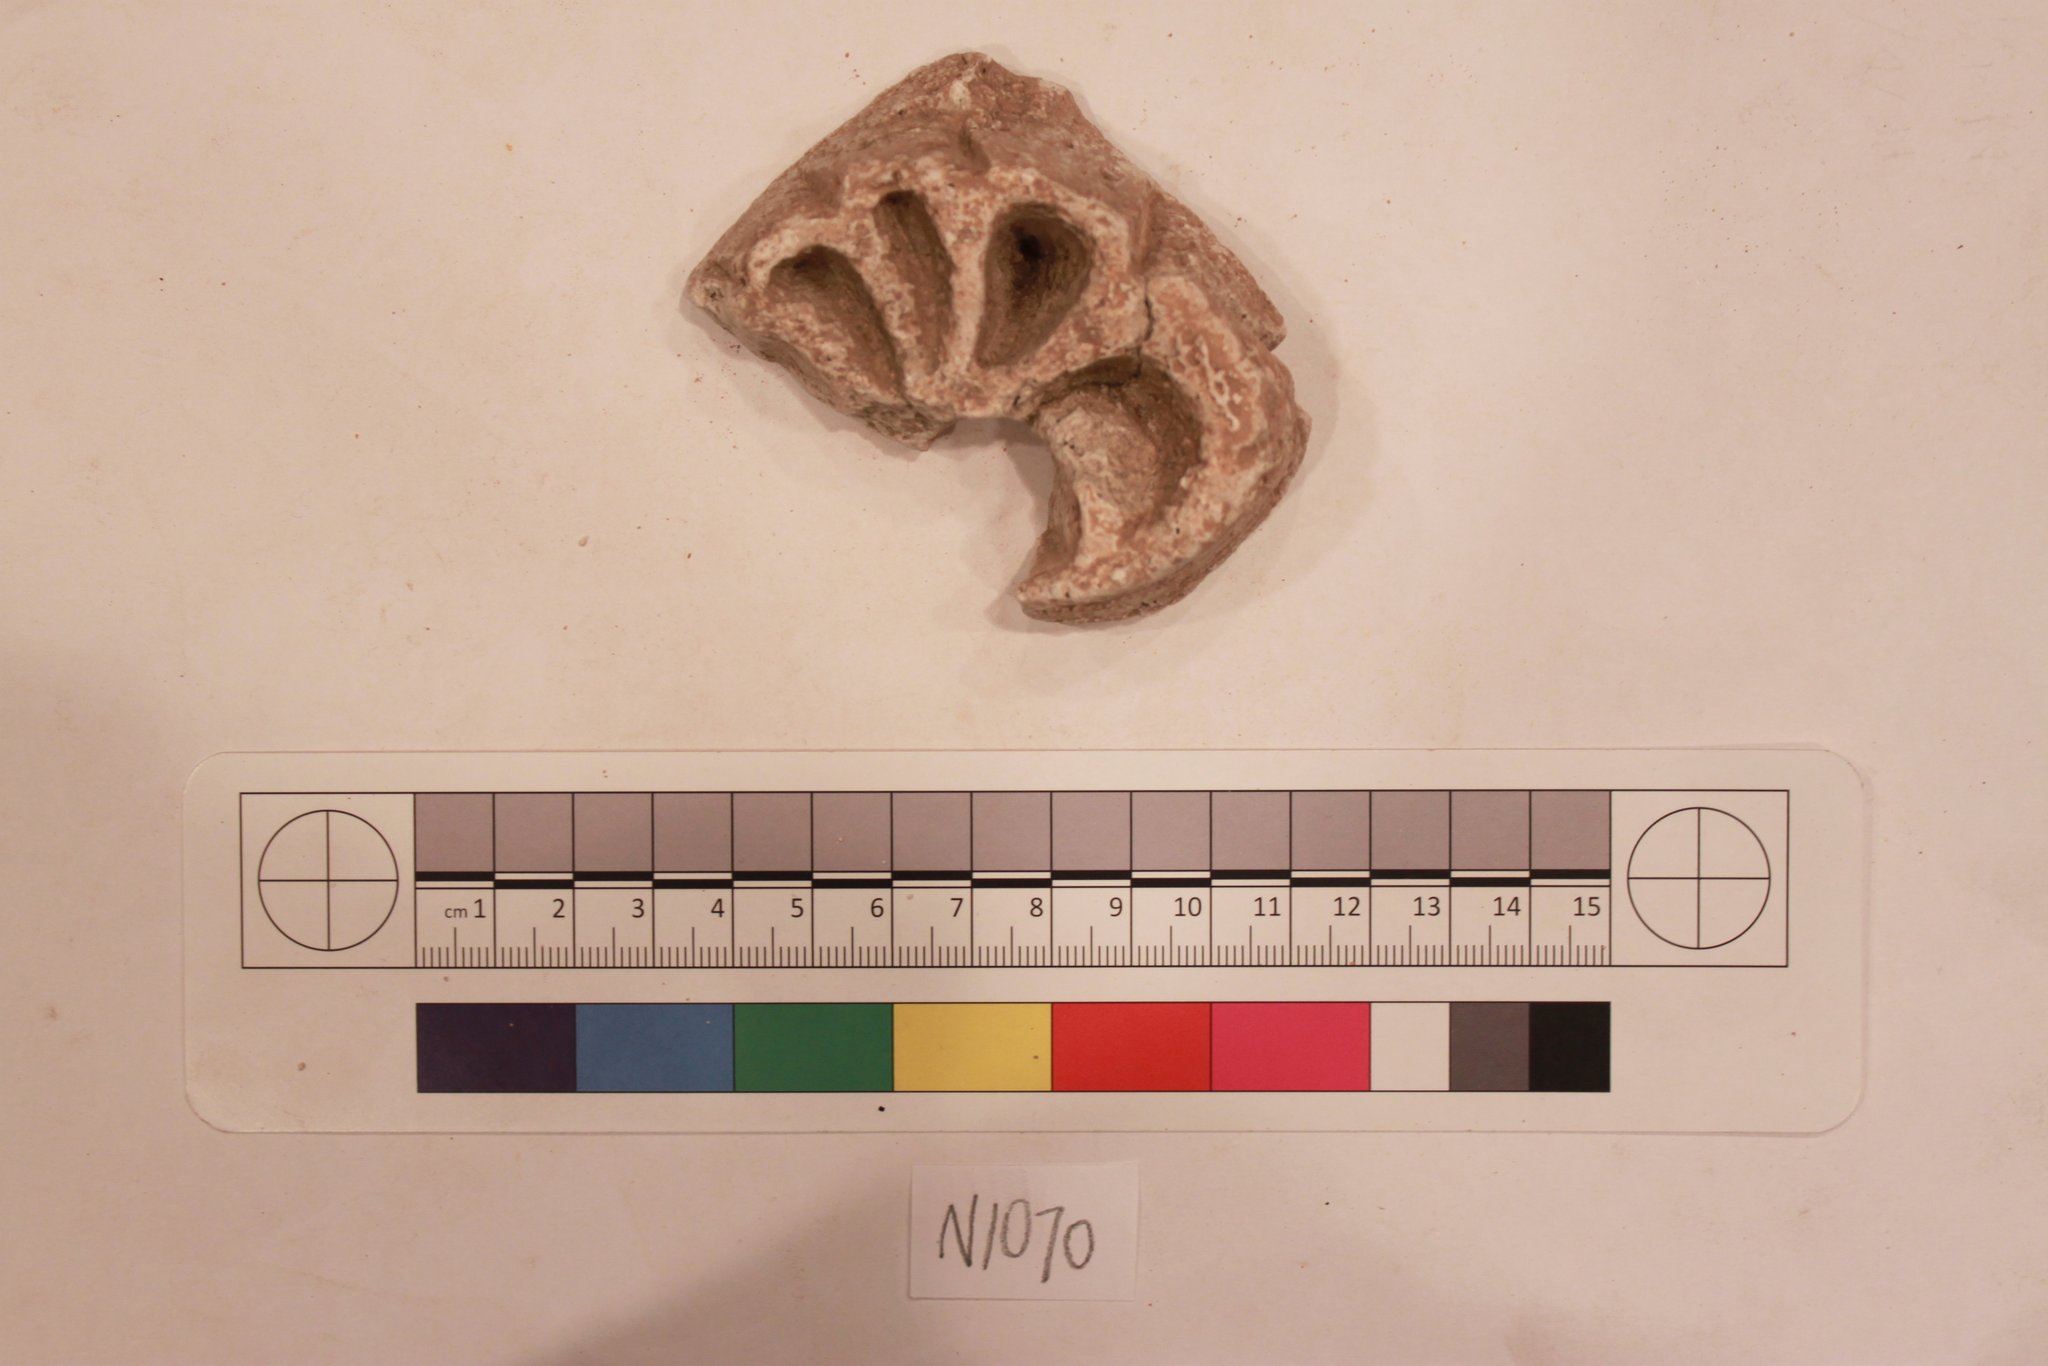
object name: fragment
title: Stucco Fragment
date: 701-1200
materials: plaster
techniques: carving, painting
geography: iran